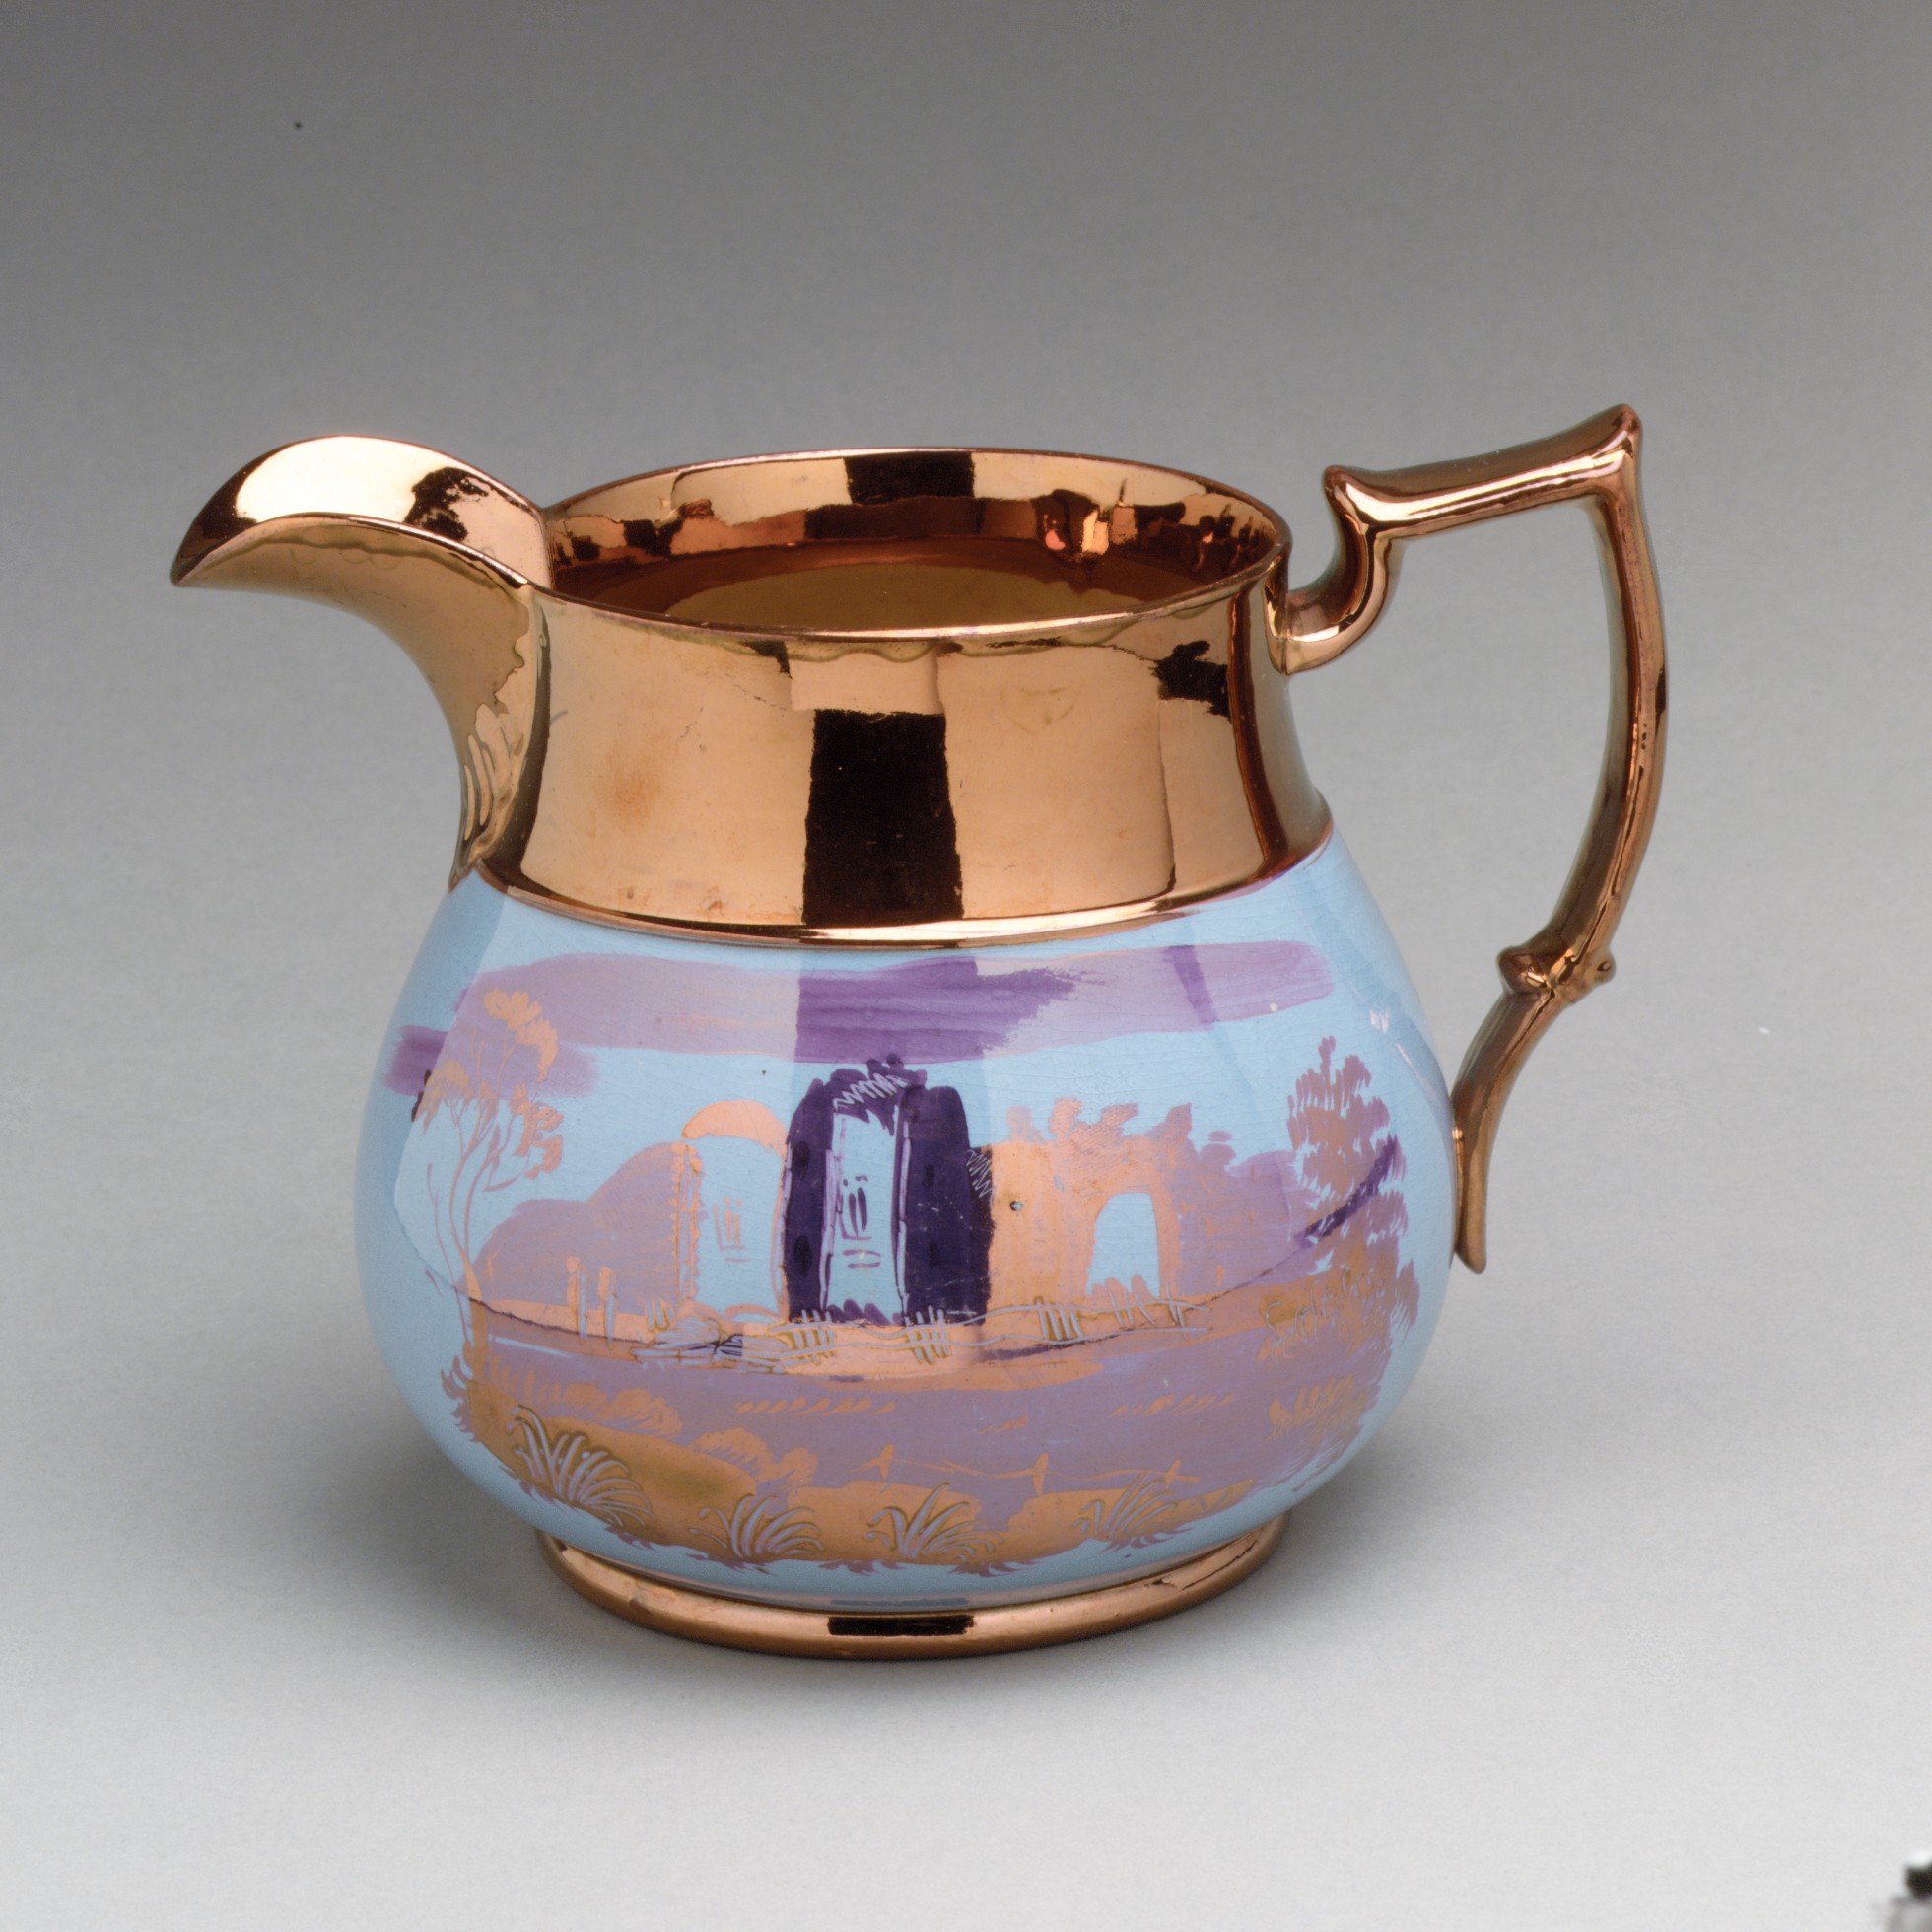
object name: pitcher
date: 1801-1900